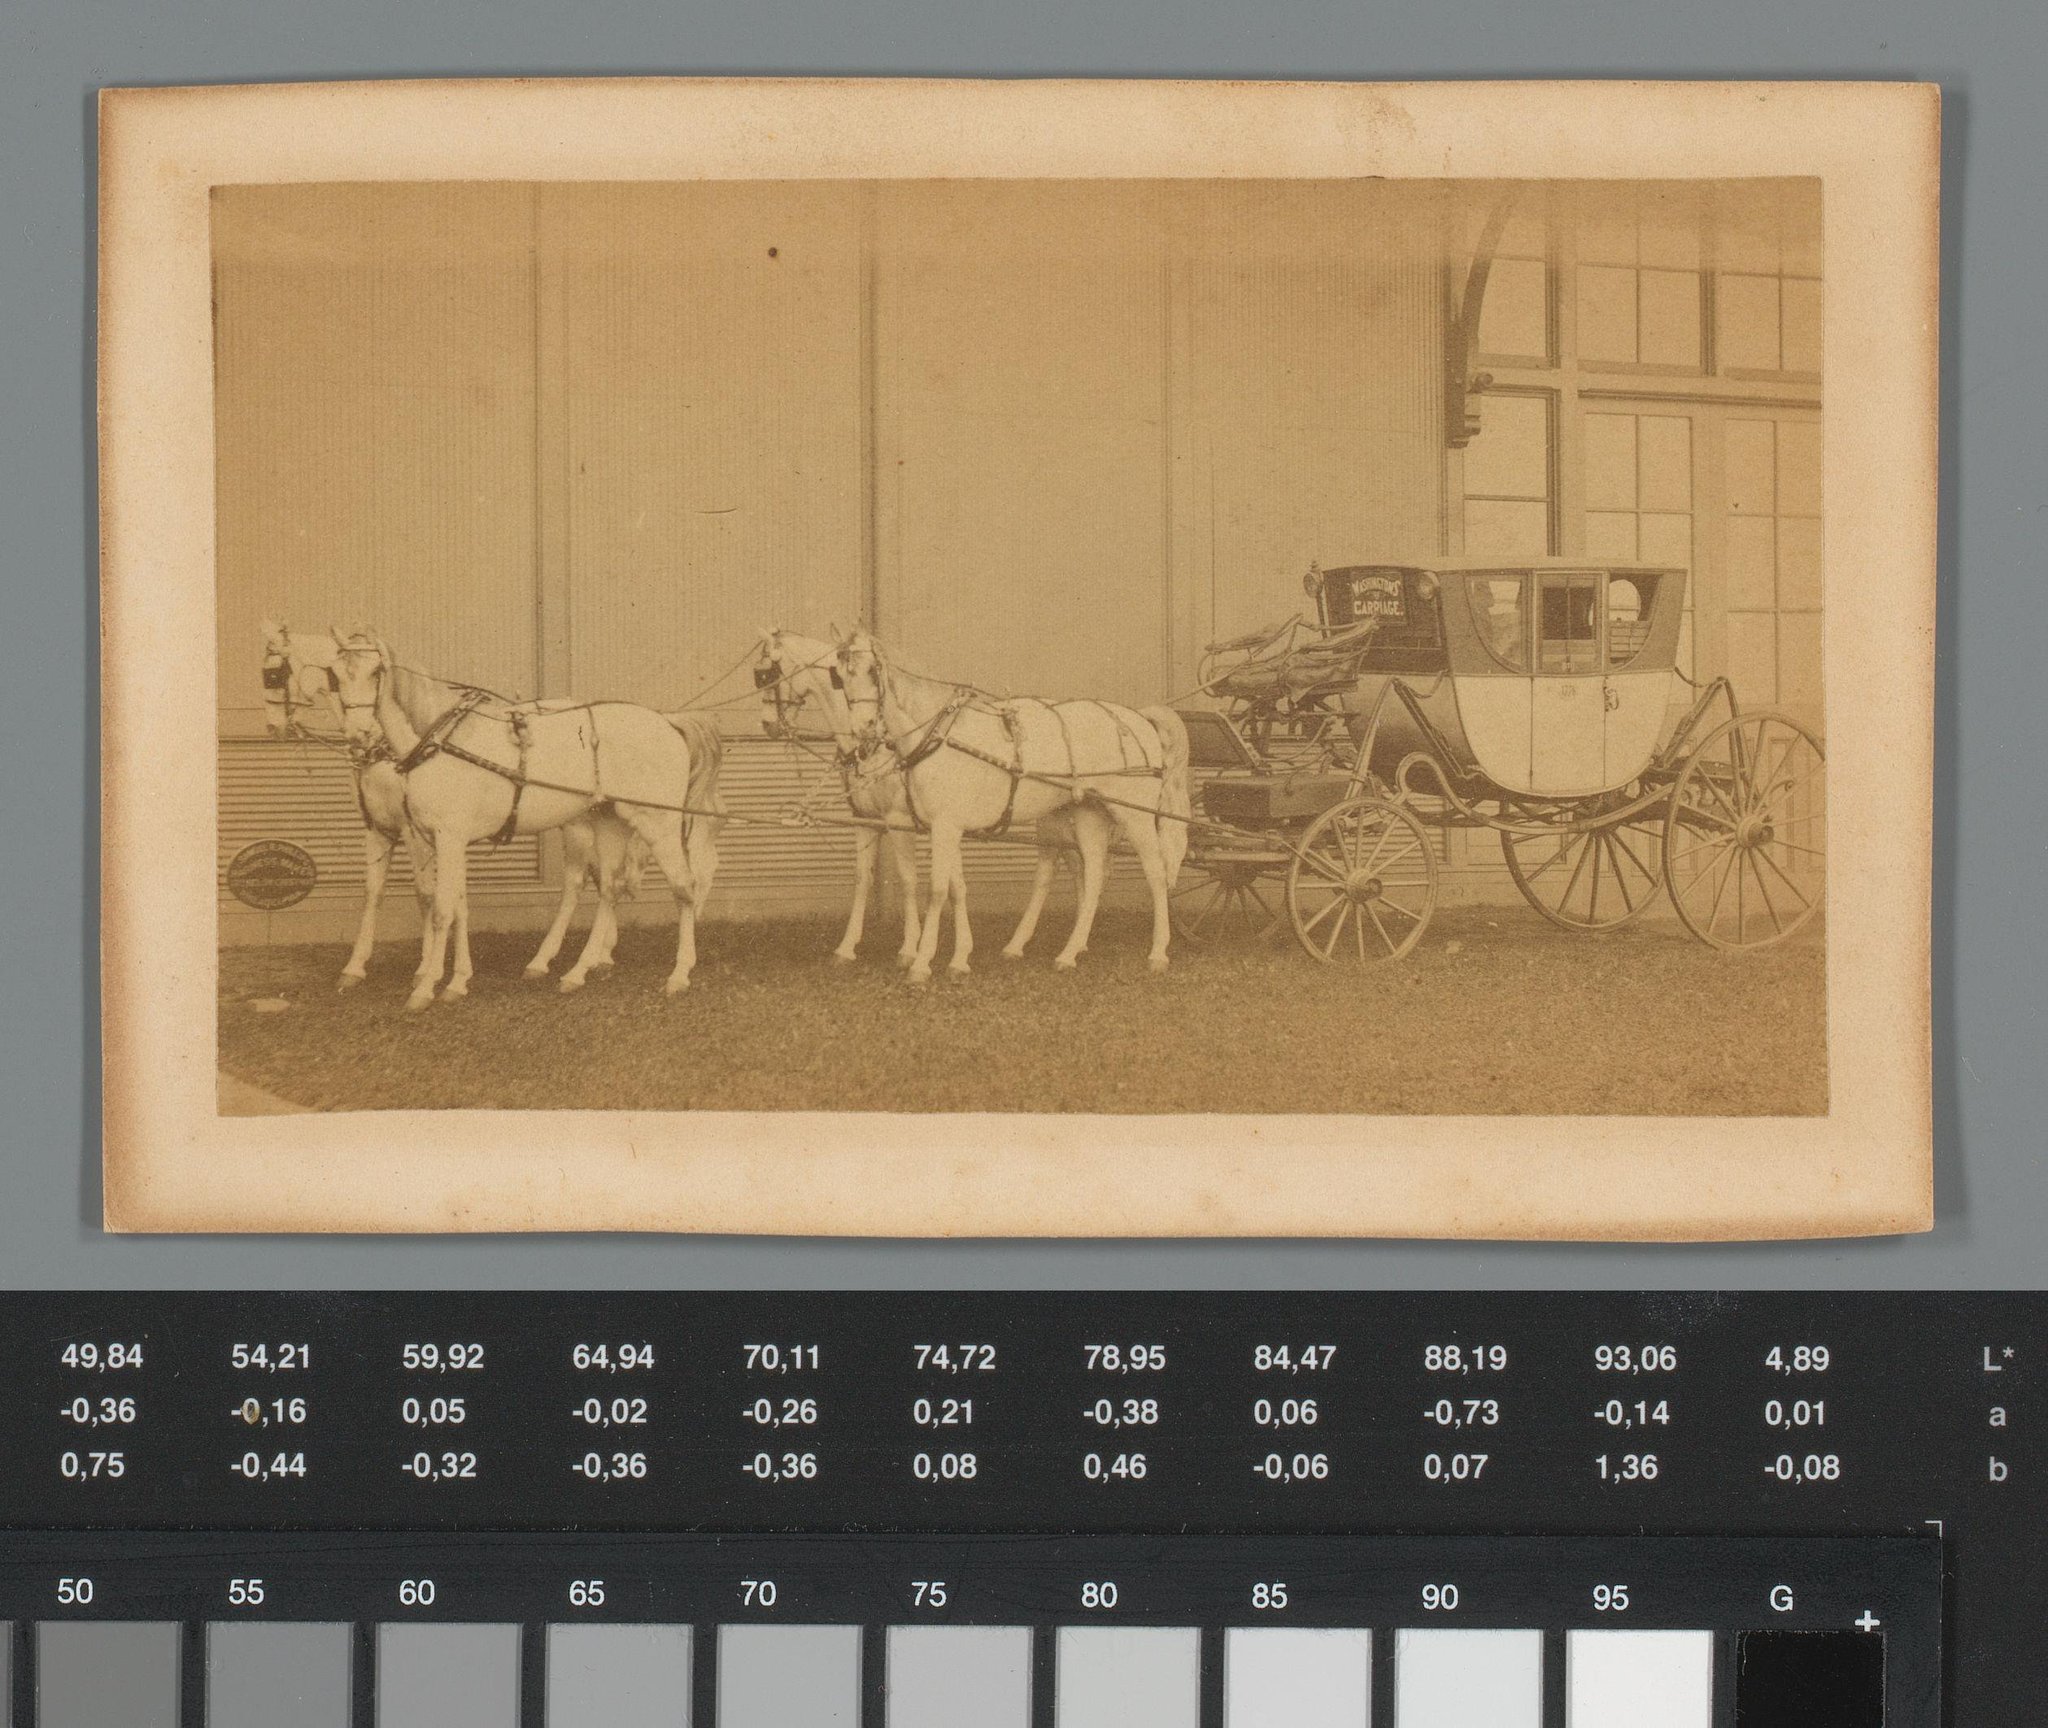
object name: photograph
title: Gezicht op een koets met paarden met reclame voor Samuel R. Phillips Harness, Saddles & Trunks, Philadelphia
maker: Anonymous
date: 1876-1915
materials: cardboard, photographic support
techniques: albumen print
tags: advertising, four-wheeled vehicle drawn by more than three animals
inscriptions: inscription: ‘(...) HIGHEST ATTAINABLE AWARD AND MEDAL, 1876./ (...)’